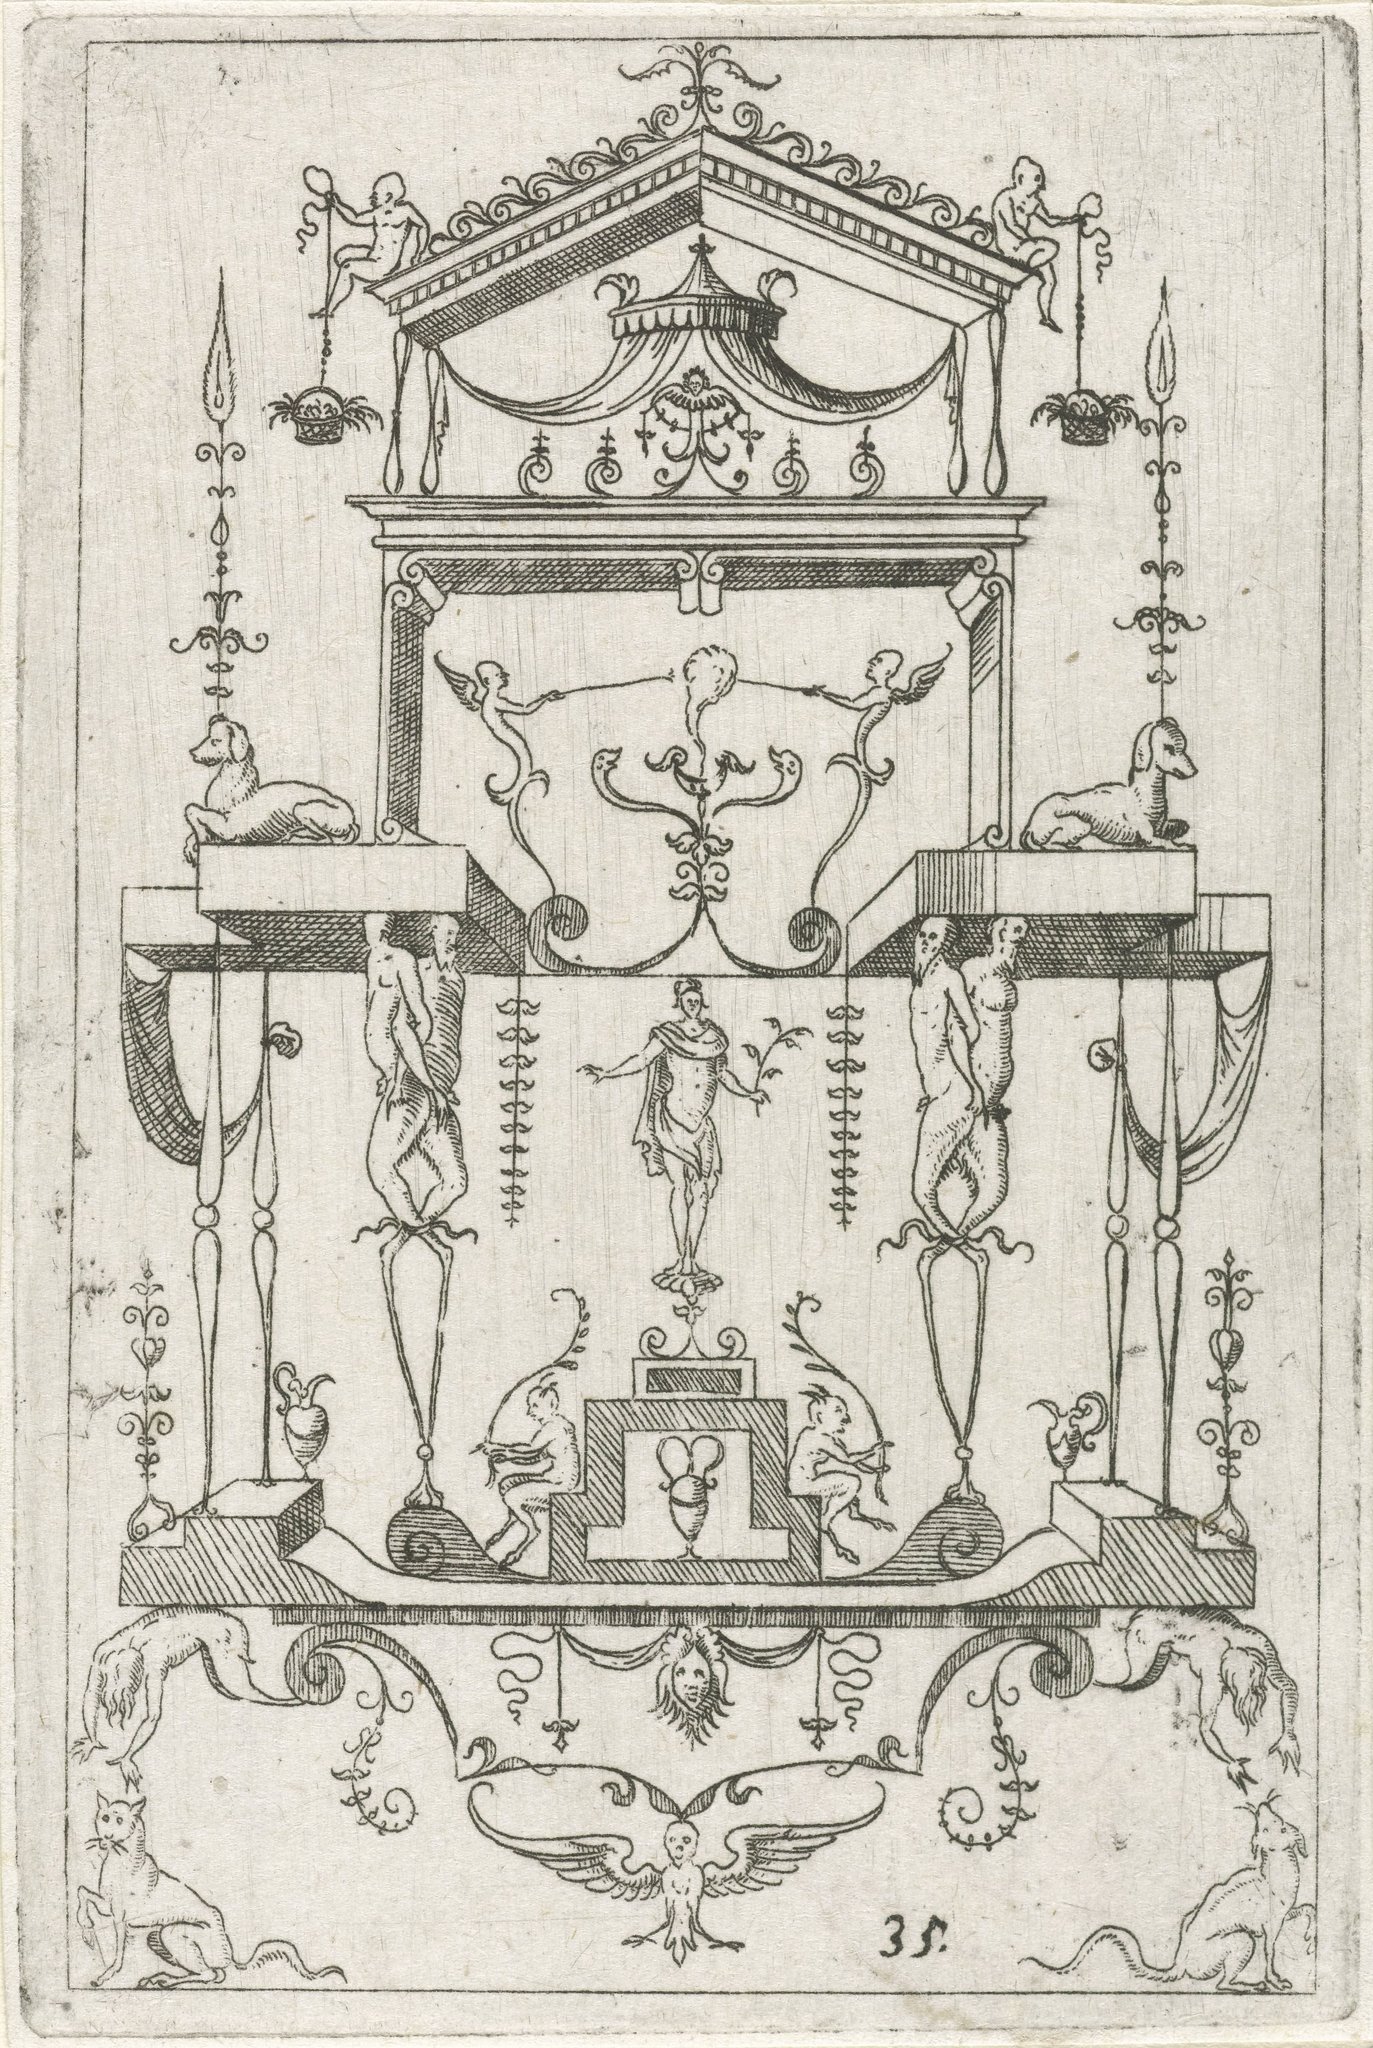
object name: print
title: Iacobus Androuetius Du Cerceau inventor ante annos non paucos conscripsit (...)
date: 1525-1594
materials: paper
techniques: etching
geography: germany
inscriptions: collector's mark: Lugt 240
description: Gelijkzijdige kopie naar prent van Jacques Androuet Ducerceau, ontleend aan een vlakdecoratie van Enea Vico. Blad uit serie met architectuurfantasieën en grotesken met fabelwezens, guirlandes, kandelabers en mascarons.